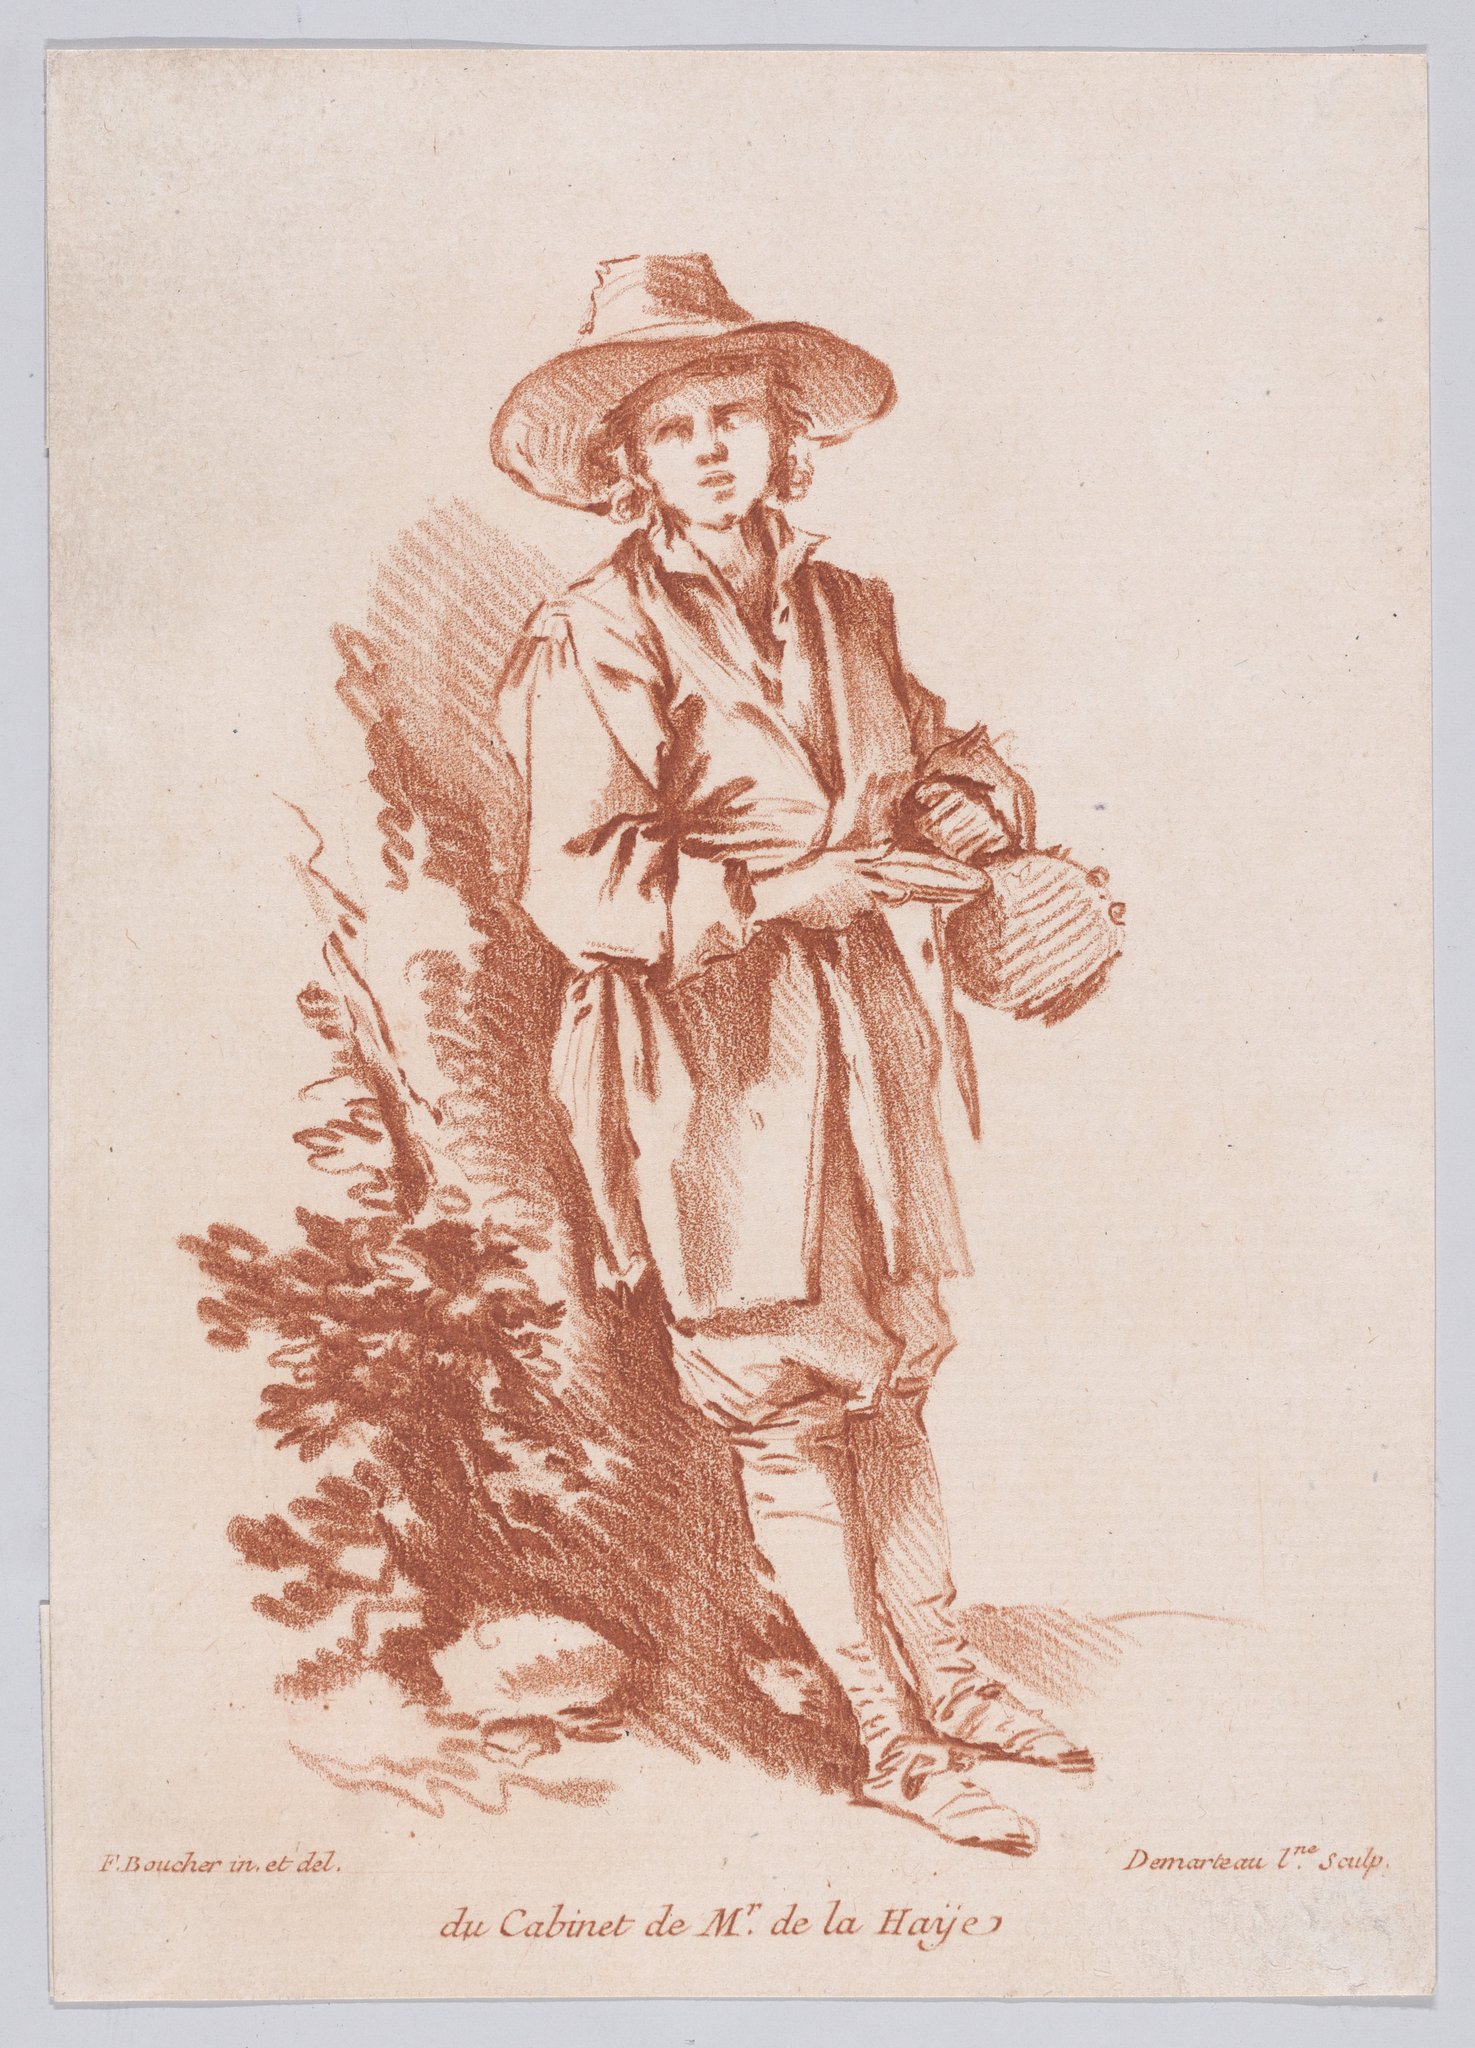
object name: print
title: Petit paysan au tambourin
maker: gilles demarteau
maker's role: artist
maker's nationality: french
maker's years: 1722-1776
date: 1701-1800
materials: ink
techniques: printmaking, etching, printing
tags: men